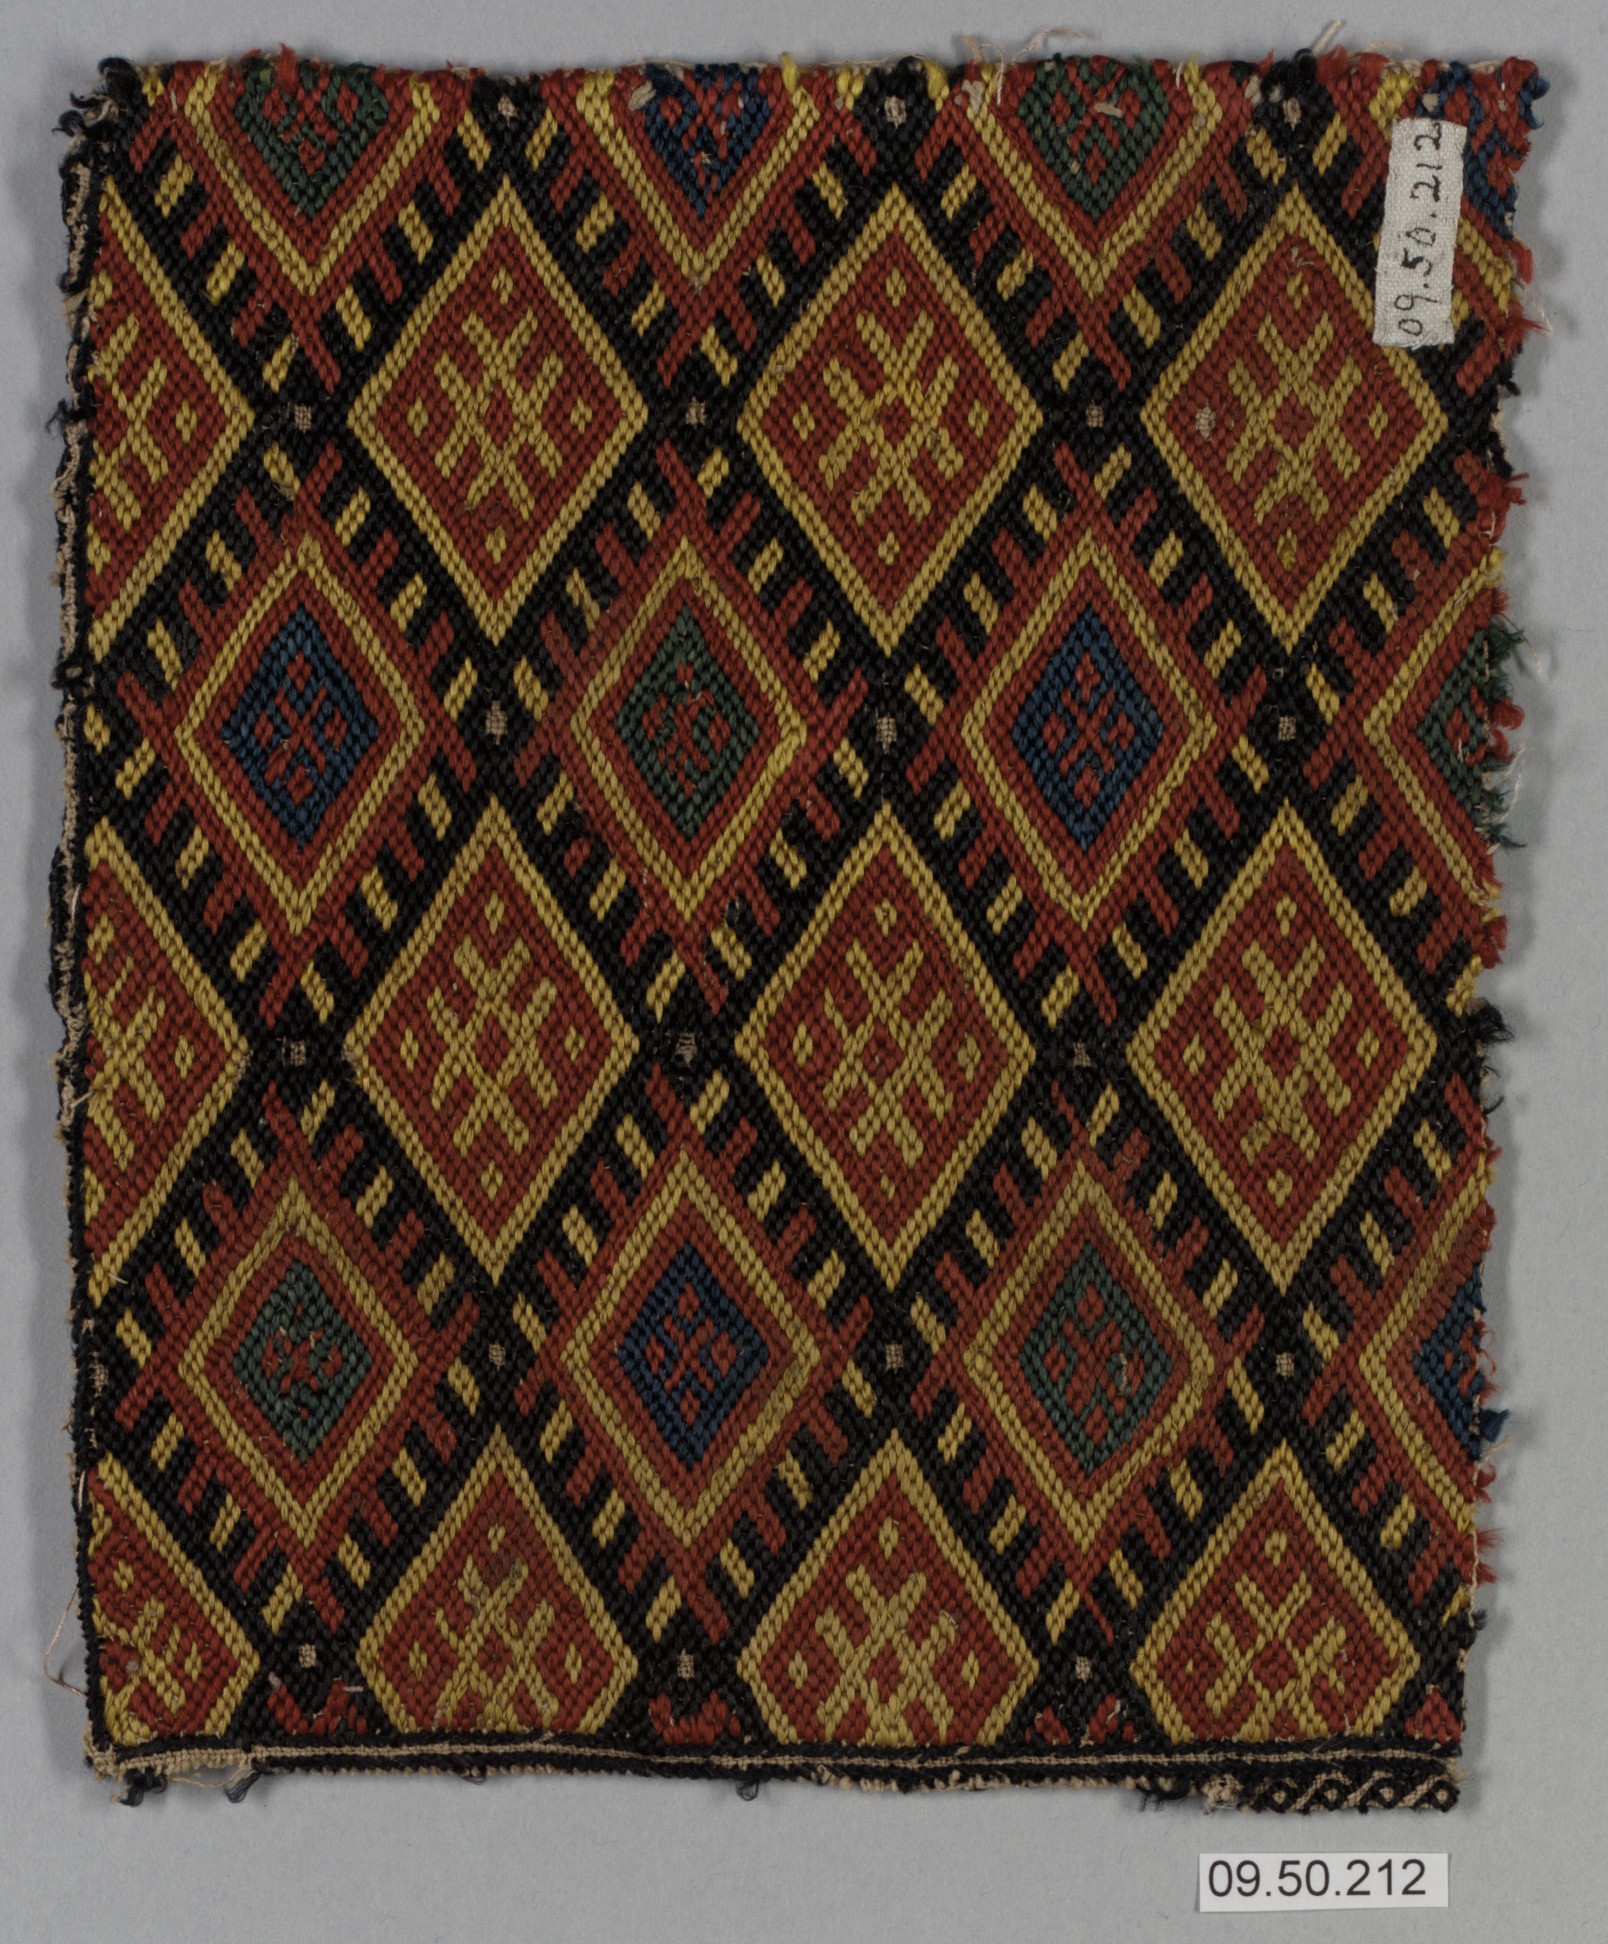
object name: textile fragment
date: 1701-1900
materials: linen, silk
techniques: embroidery, weave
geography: morocco